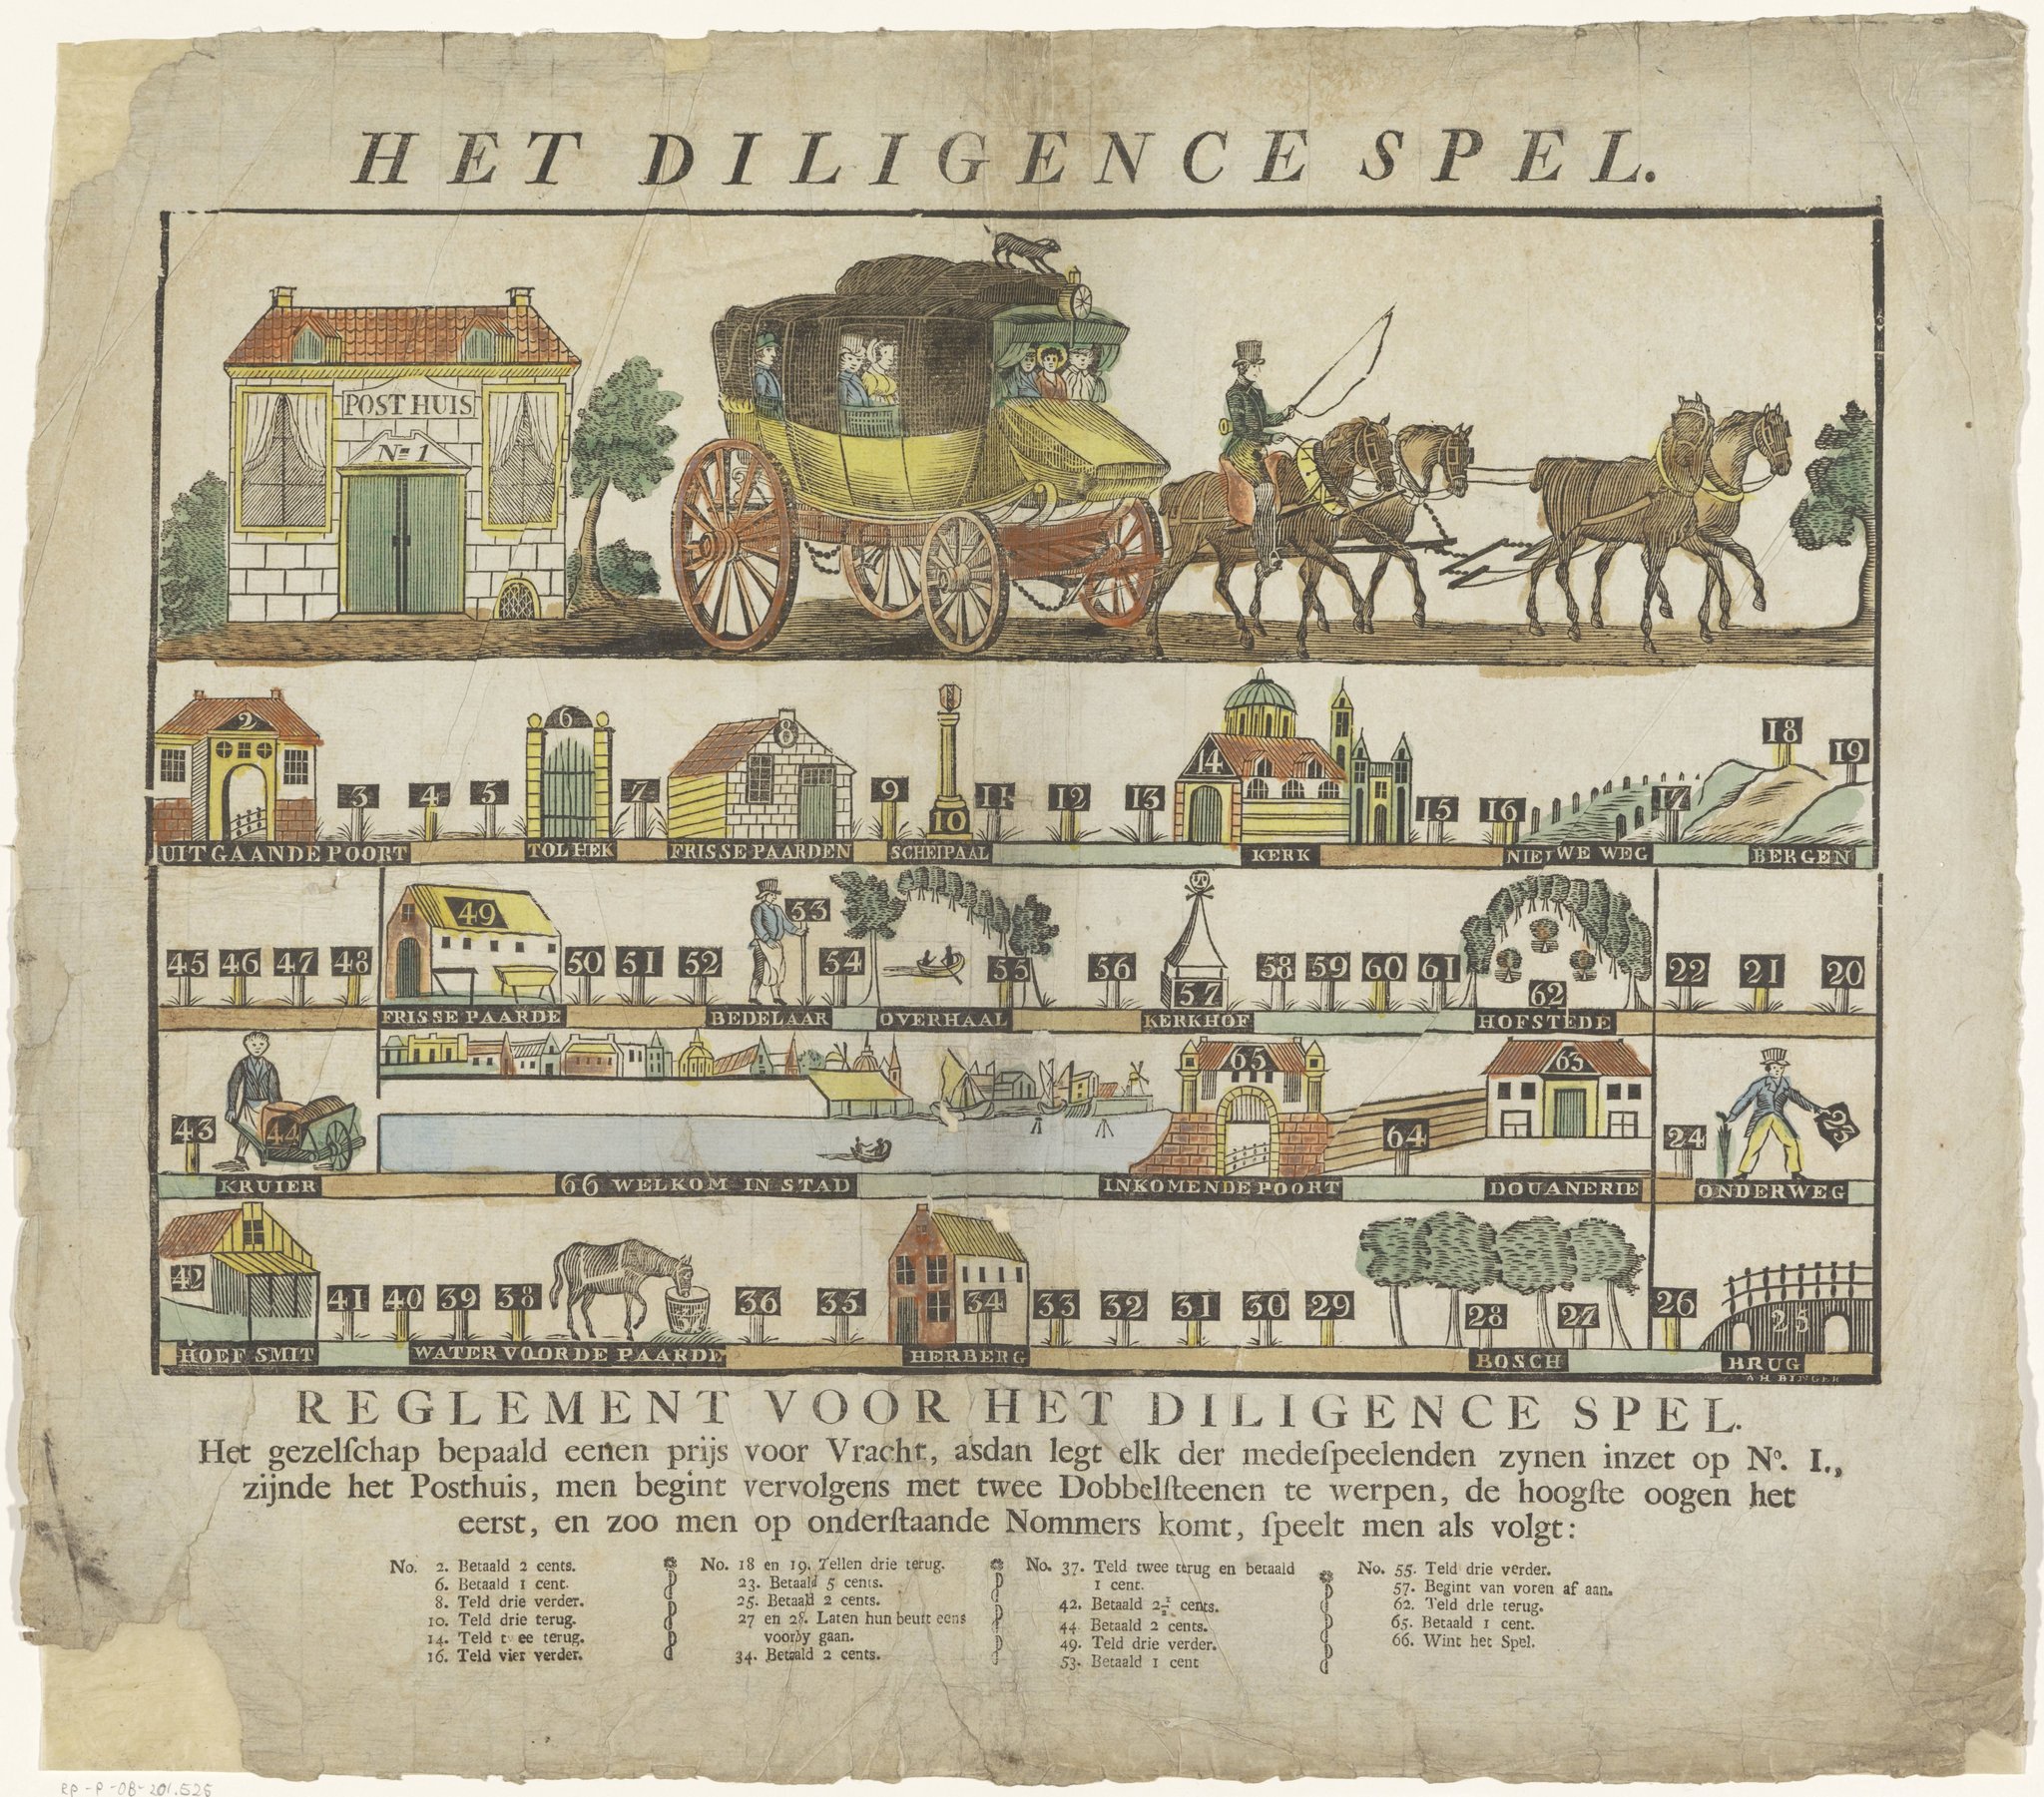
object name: popular print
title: Het diligence spel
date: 1800-1849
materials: paper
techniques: colour, letterpress printing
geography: netherlands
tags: diligence, omnibus, horse-tram, board-games of chance, board-games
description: Bordspel met vijf horizontale stroken met nummers 1 tot en met 48. De bovenste strook toont een afbeelding van het posthuis en de diligence of reiskoets, getrokken door vier paarden. De andere vier stroken tonen plaatsen waar de diligence allemaal langs gaat. In de ondermarge de spelregels, boven de titel van het spel.